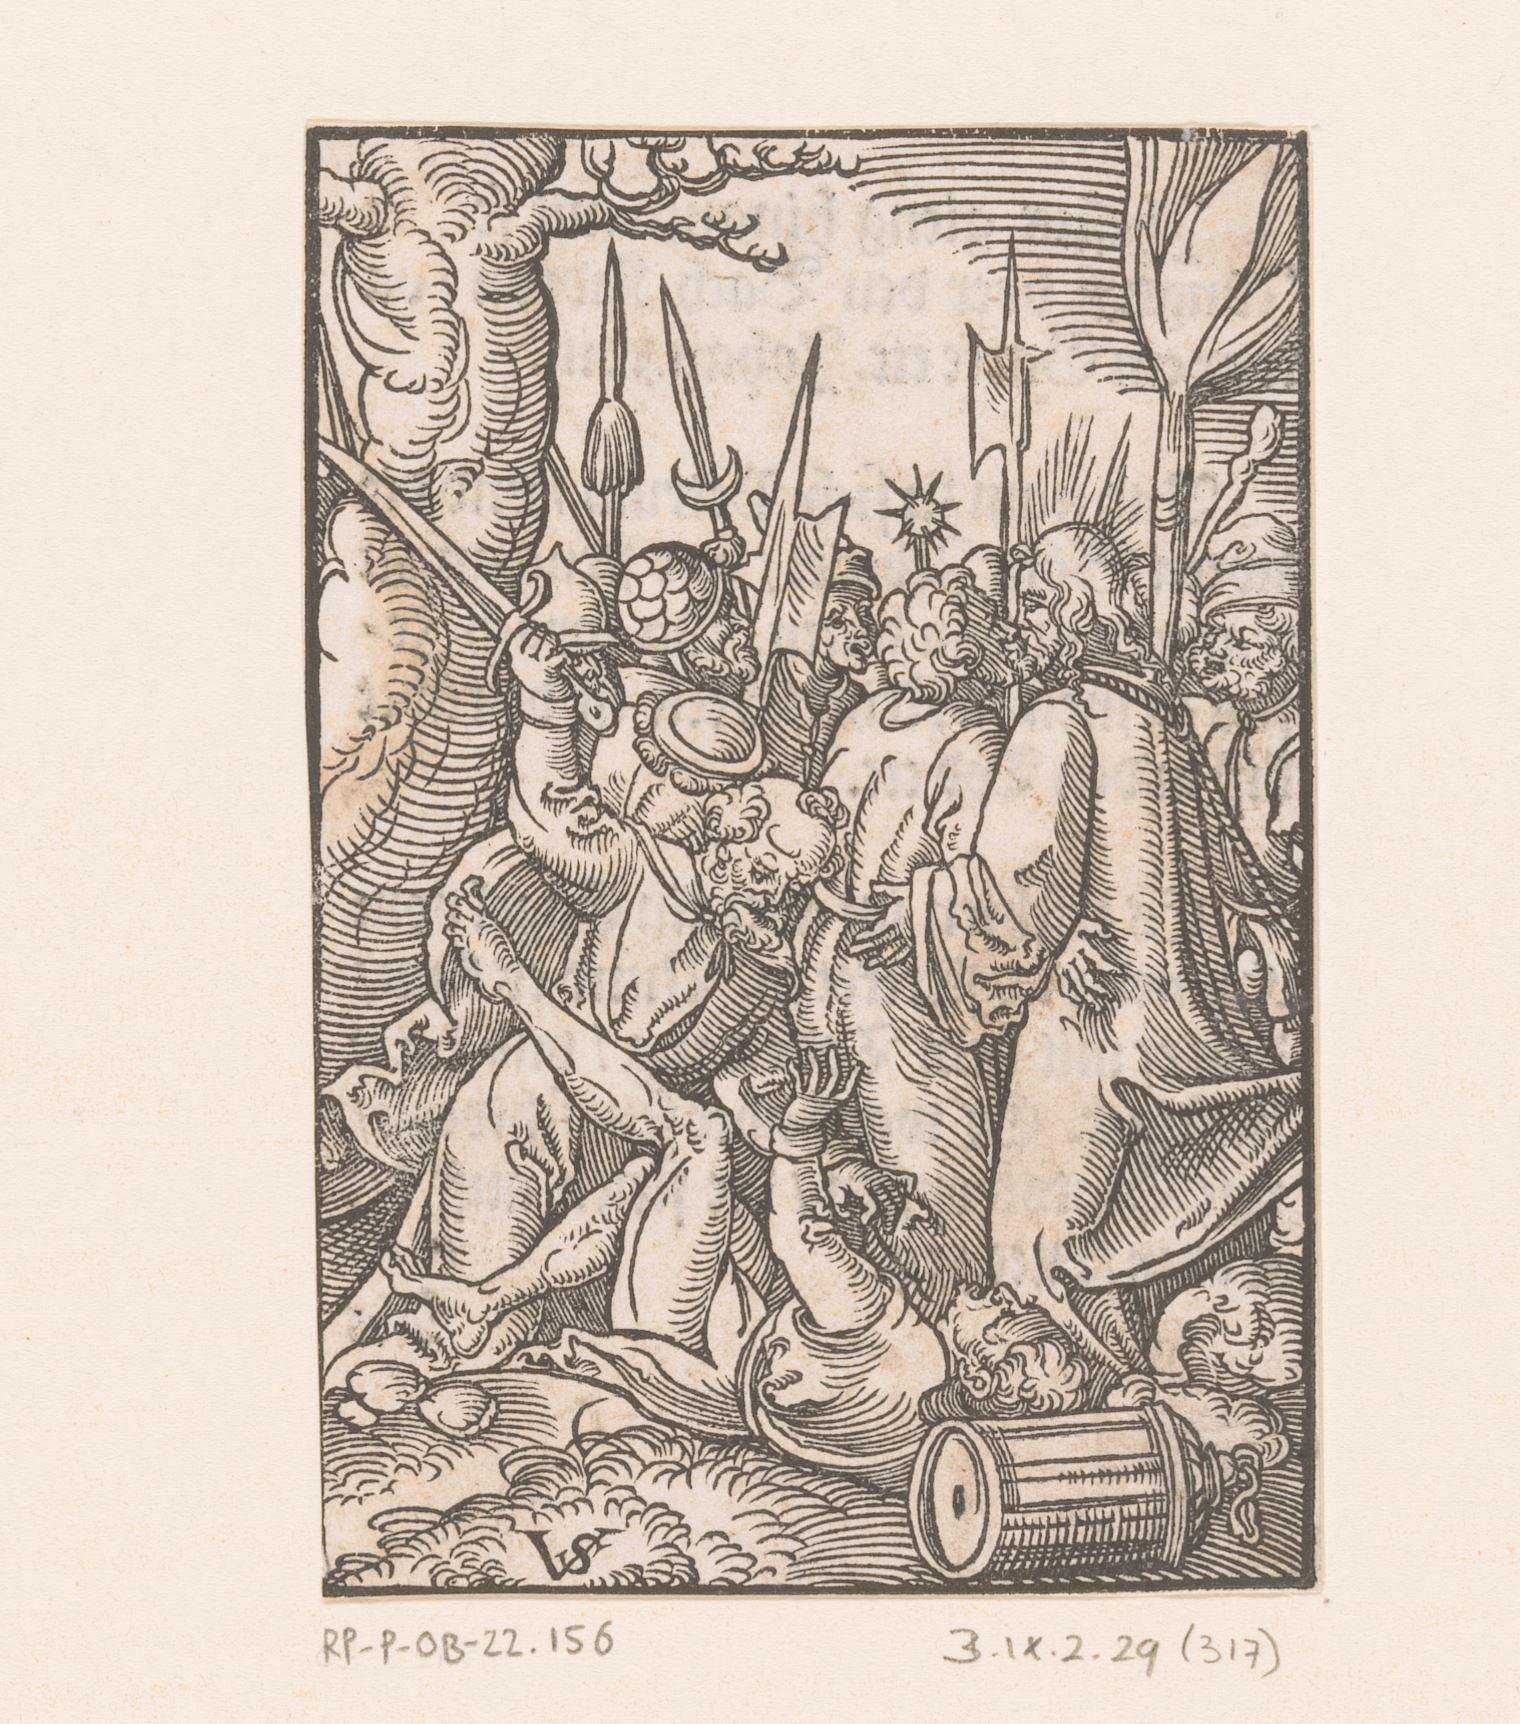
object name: book illustration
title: Verraad van Christus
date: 1552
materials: paper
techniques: woodcut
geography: nuremberg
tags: christ's arrest, trial, and torture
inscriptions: number: ‘181’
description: Gebruikt voor verschillende publicaties die werden gedrukt door Valentin Geißler tussen 1552 en 1560 te Neurenberg.